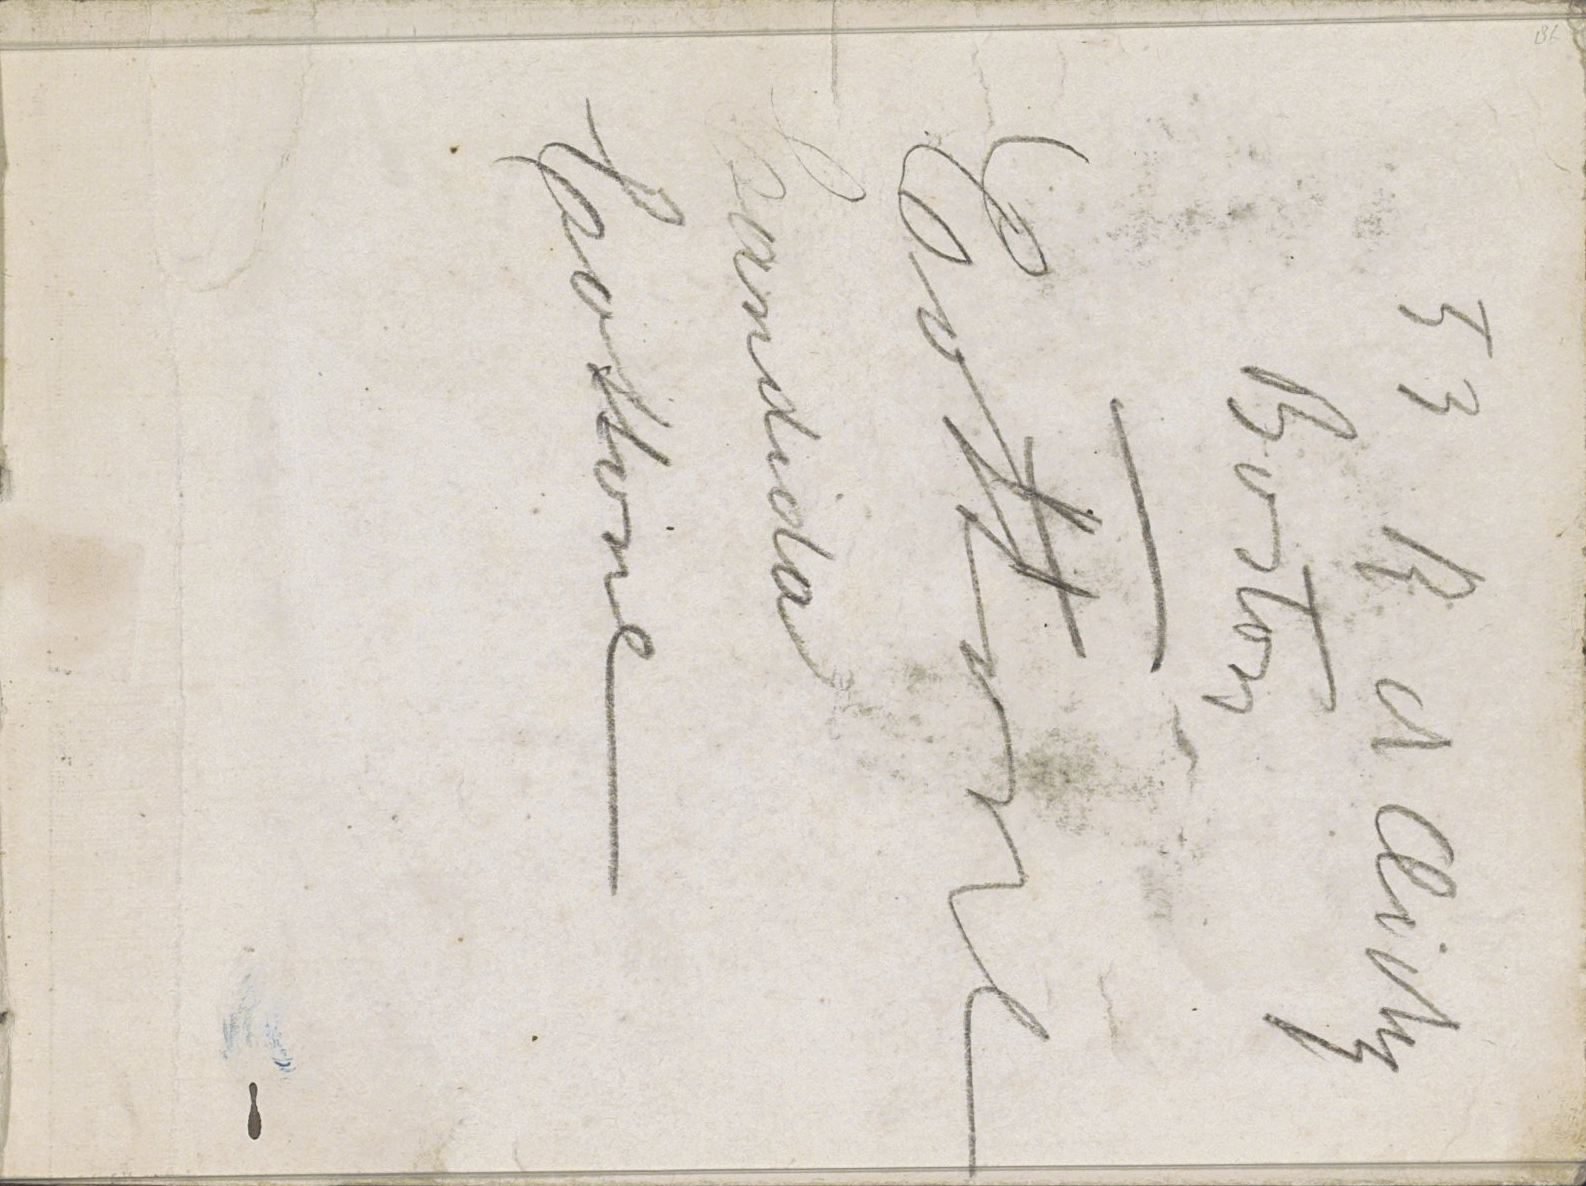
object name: endleaf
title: Annotaties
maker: isaac israels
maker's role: draughtsman, painter, print maker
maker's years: 1865-1934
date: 1875-1934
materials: chalk, paper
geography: paris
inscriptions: annotation: ‘53 R. de Clichy / Boston / Cottone / Candida / Cottone’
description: Pagina 86, achterste schutblad, uit schetsboek XLV met 85 pagina's.